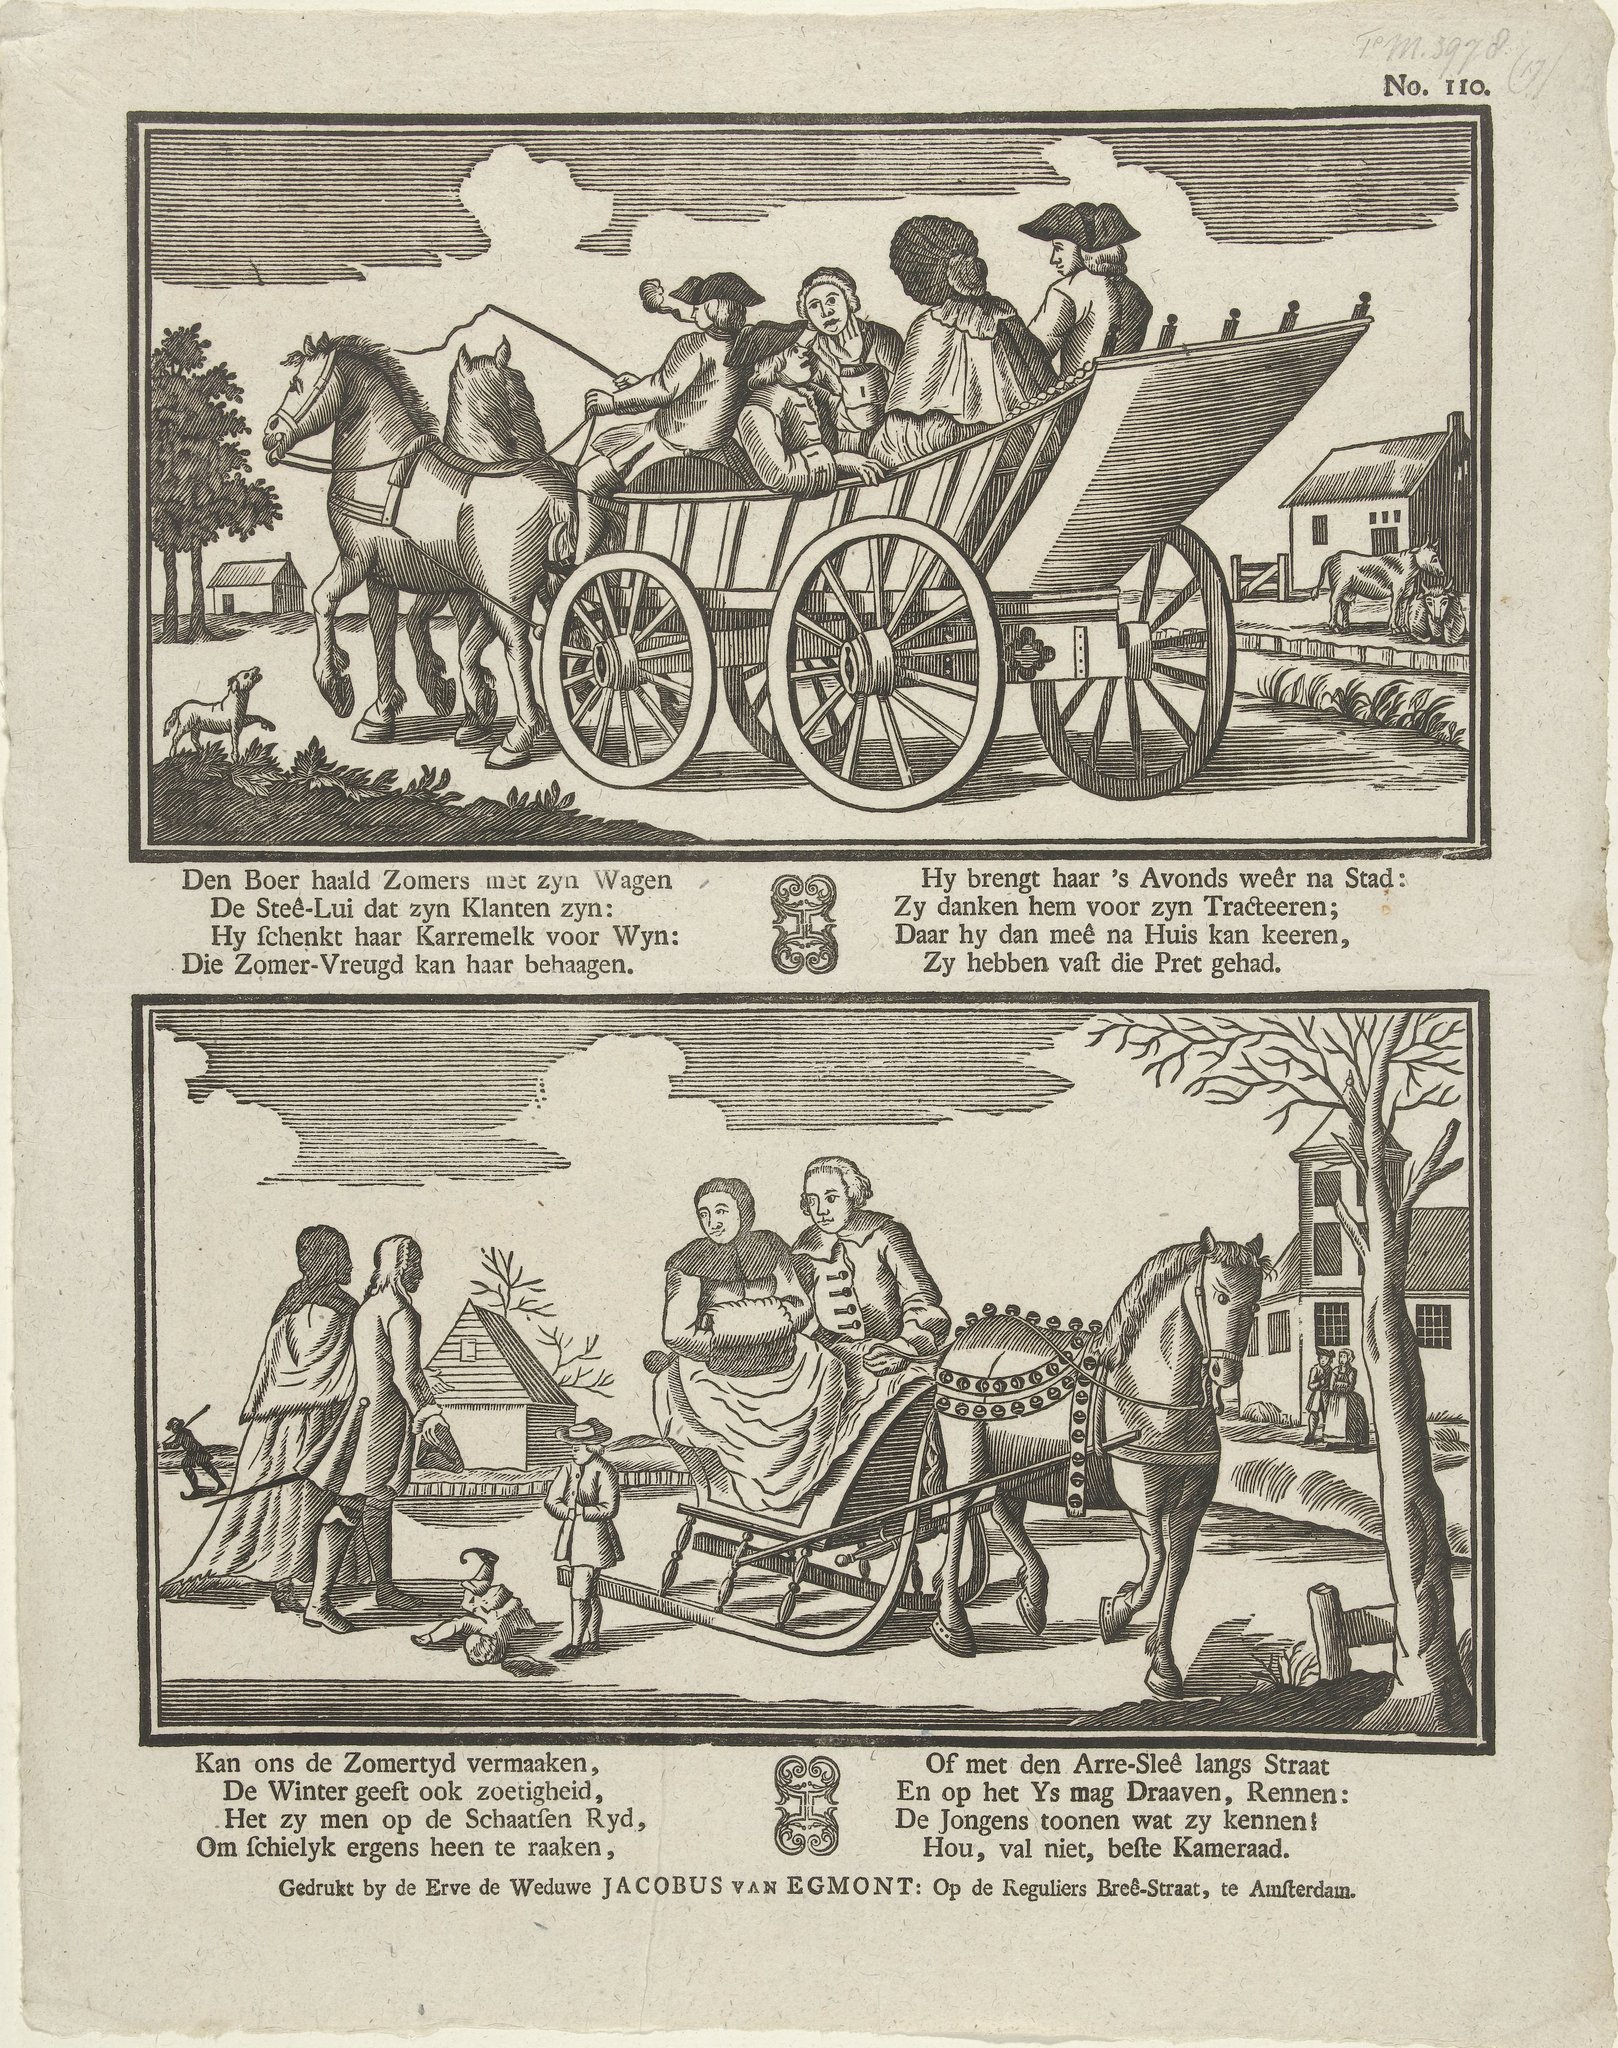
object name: print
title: Zomer- en wintervreugd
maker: Anonymous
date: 1761-1804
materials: paper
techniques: letterpress printing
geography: netherlands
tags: sleigh, sledge (non-sport), (farm) wagon, freight wagon, cart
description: Blad met 2 voorstellingen. Boven maakt een gezelschap in de zomer een rit in een open wagen. Onder een echtpaar in de winter in de arrenslee op het ijs. Onder elk plaatje twee vierregelige verzen. Genummerd rechtsboven: No. 110.